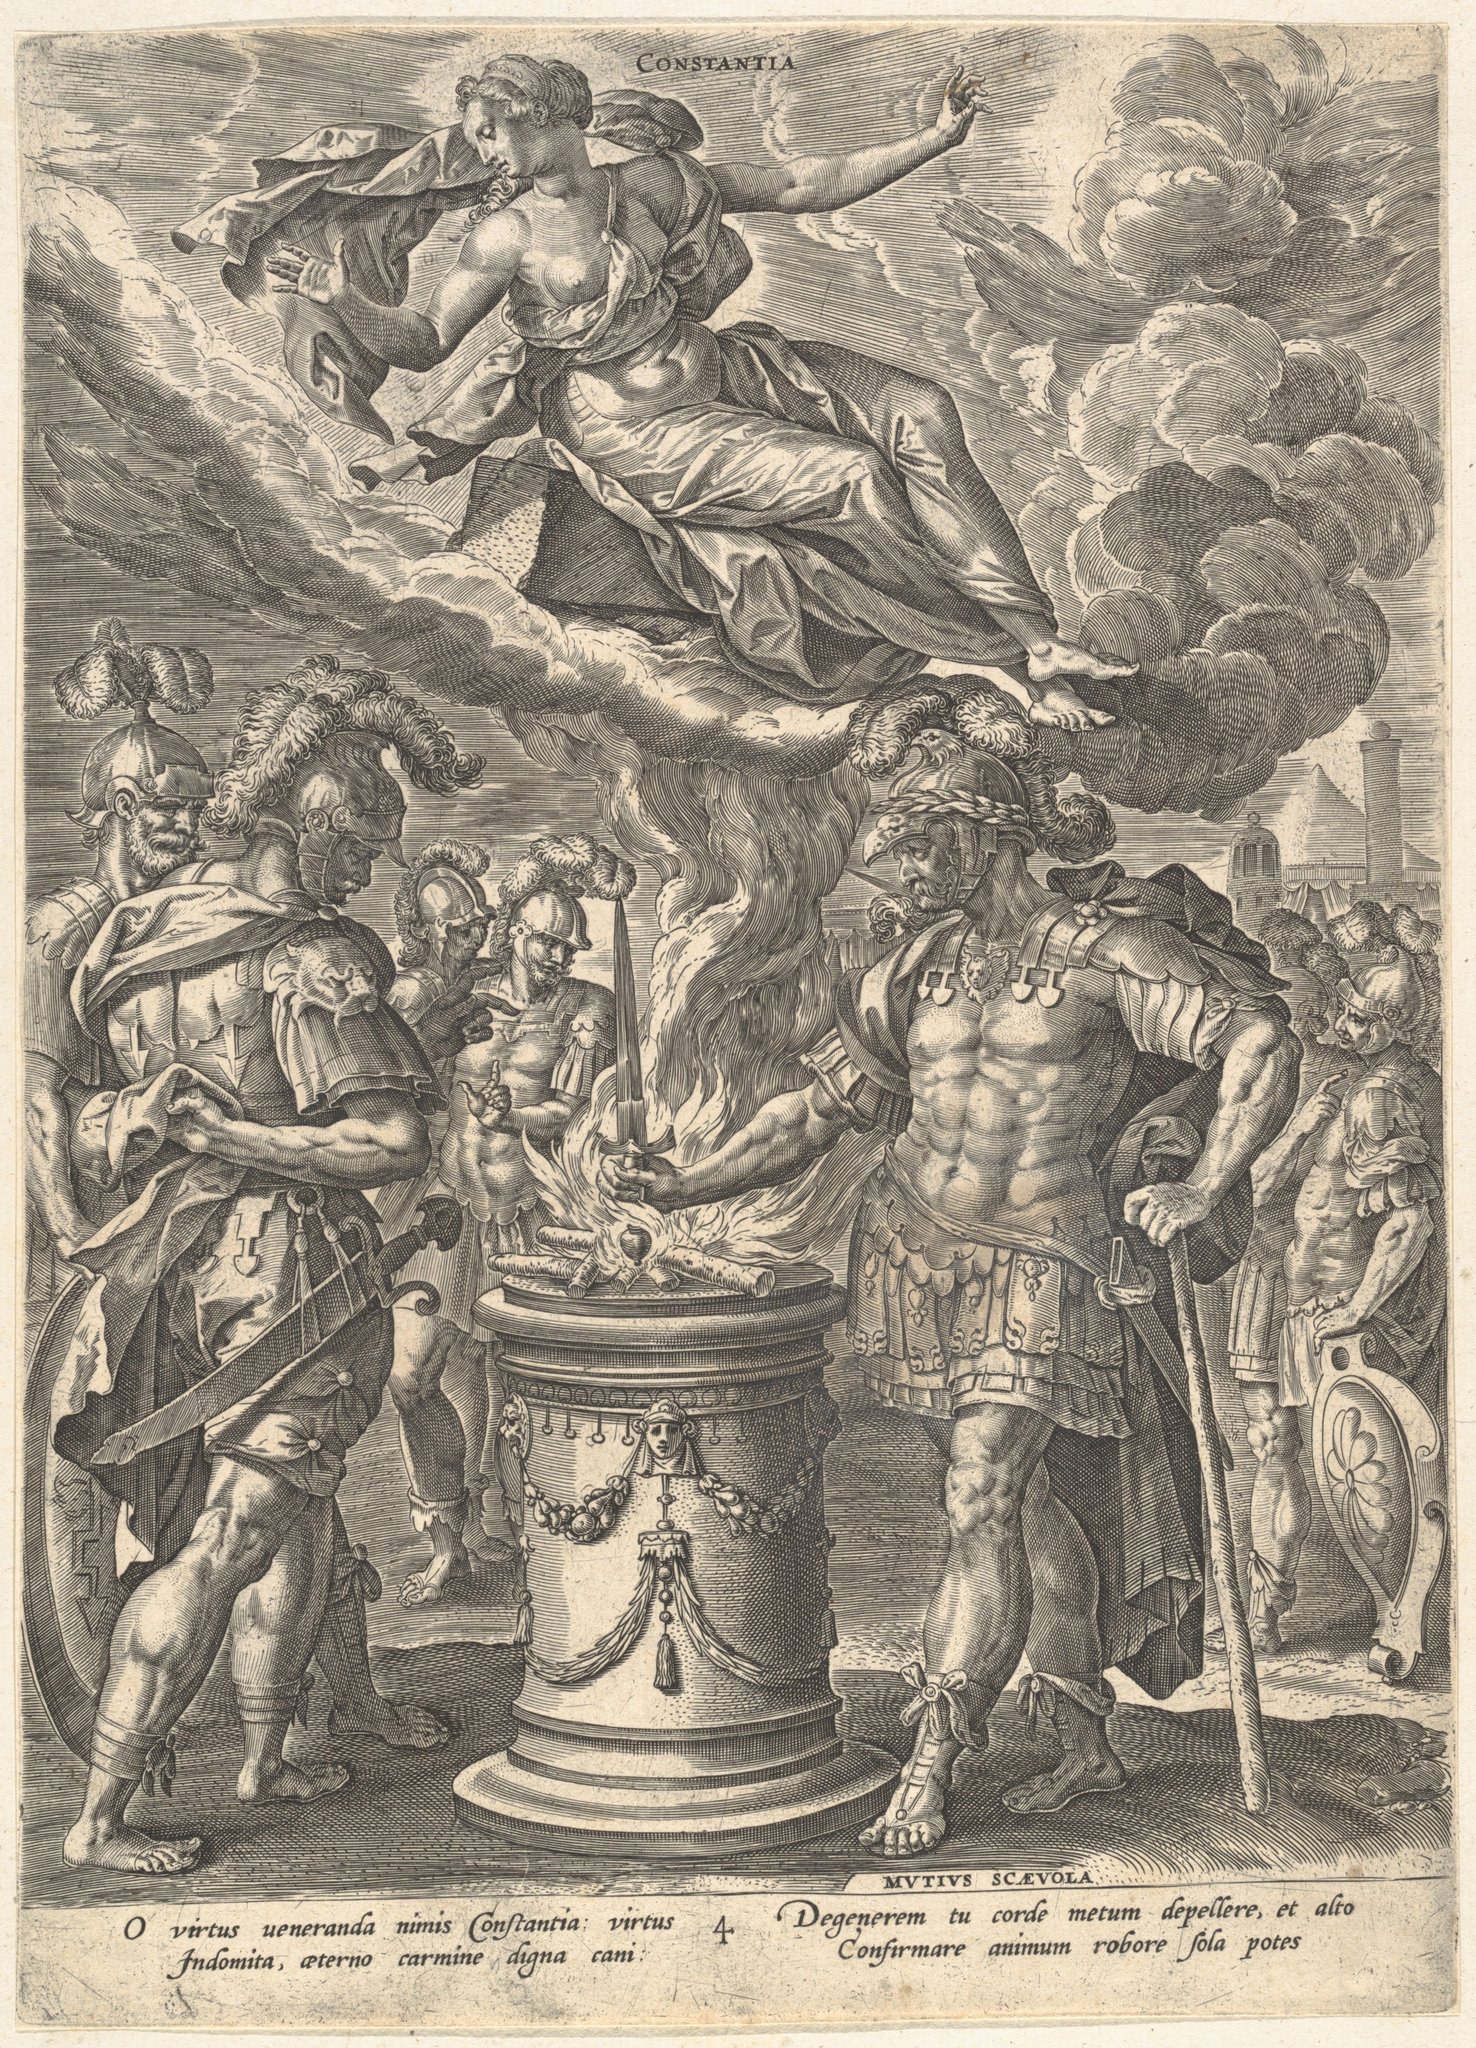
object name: print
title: Constantia, from "Virtues"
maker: maerten de vos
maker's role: artist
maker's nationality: netherlandish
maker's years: 1532-1603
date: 1581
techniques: engraving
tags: weapons,men,female nudes